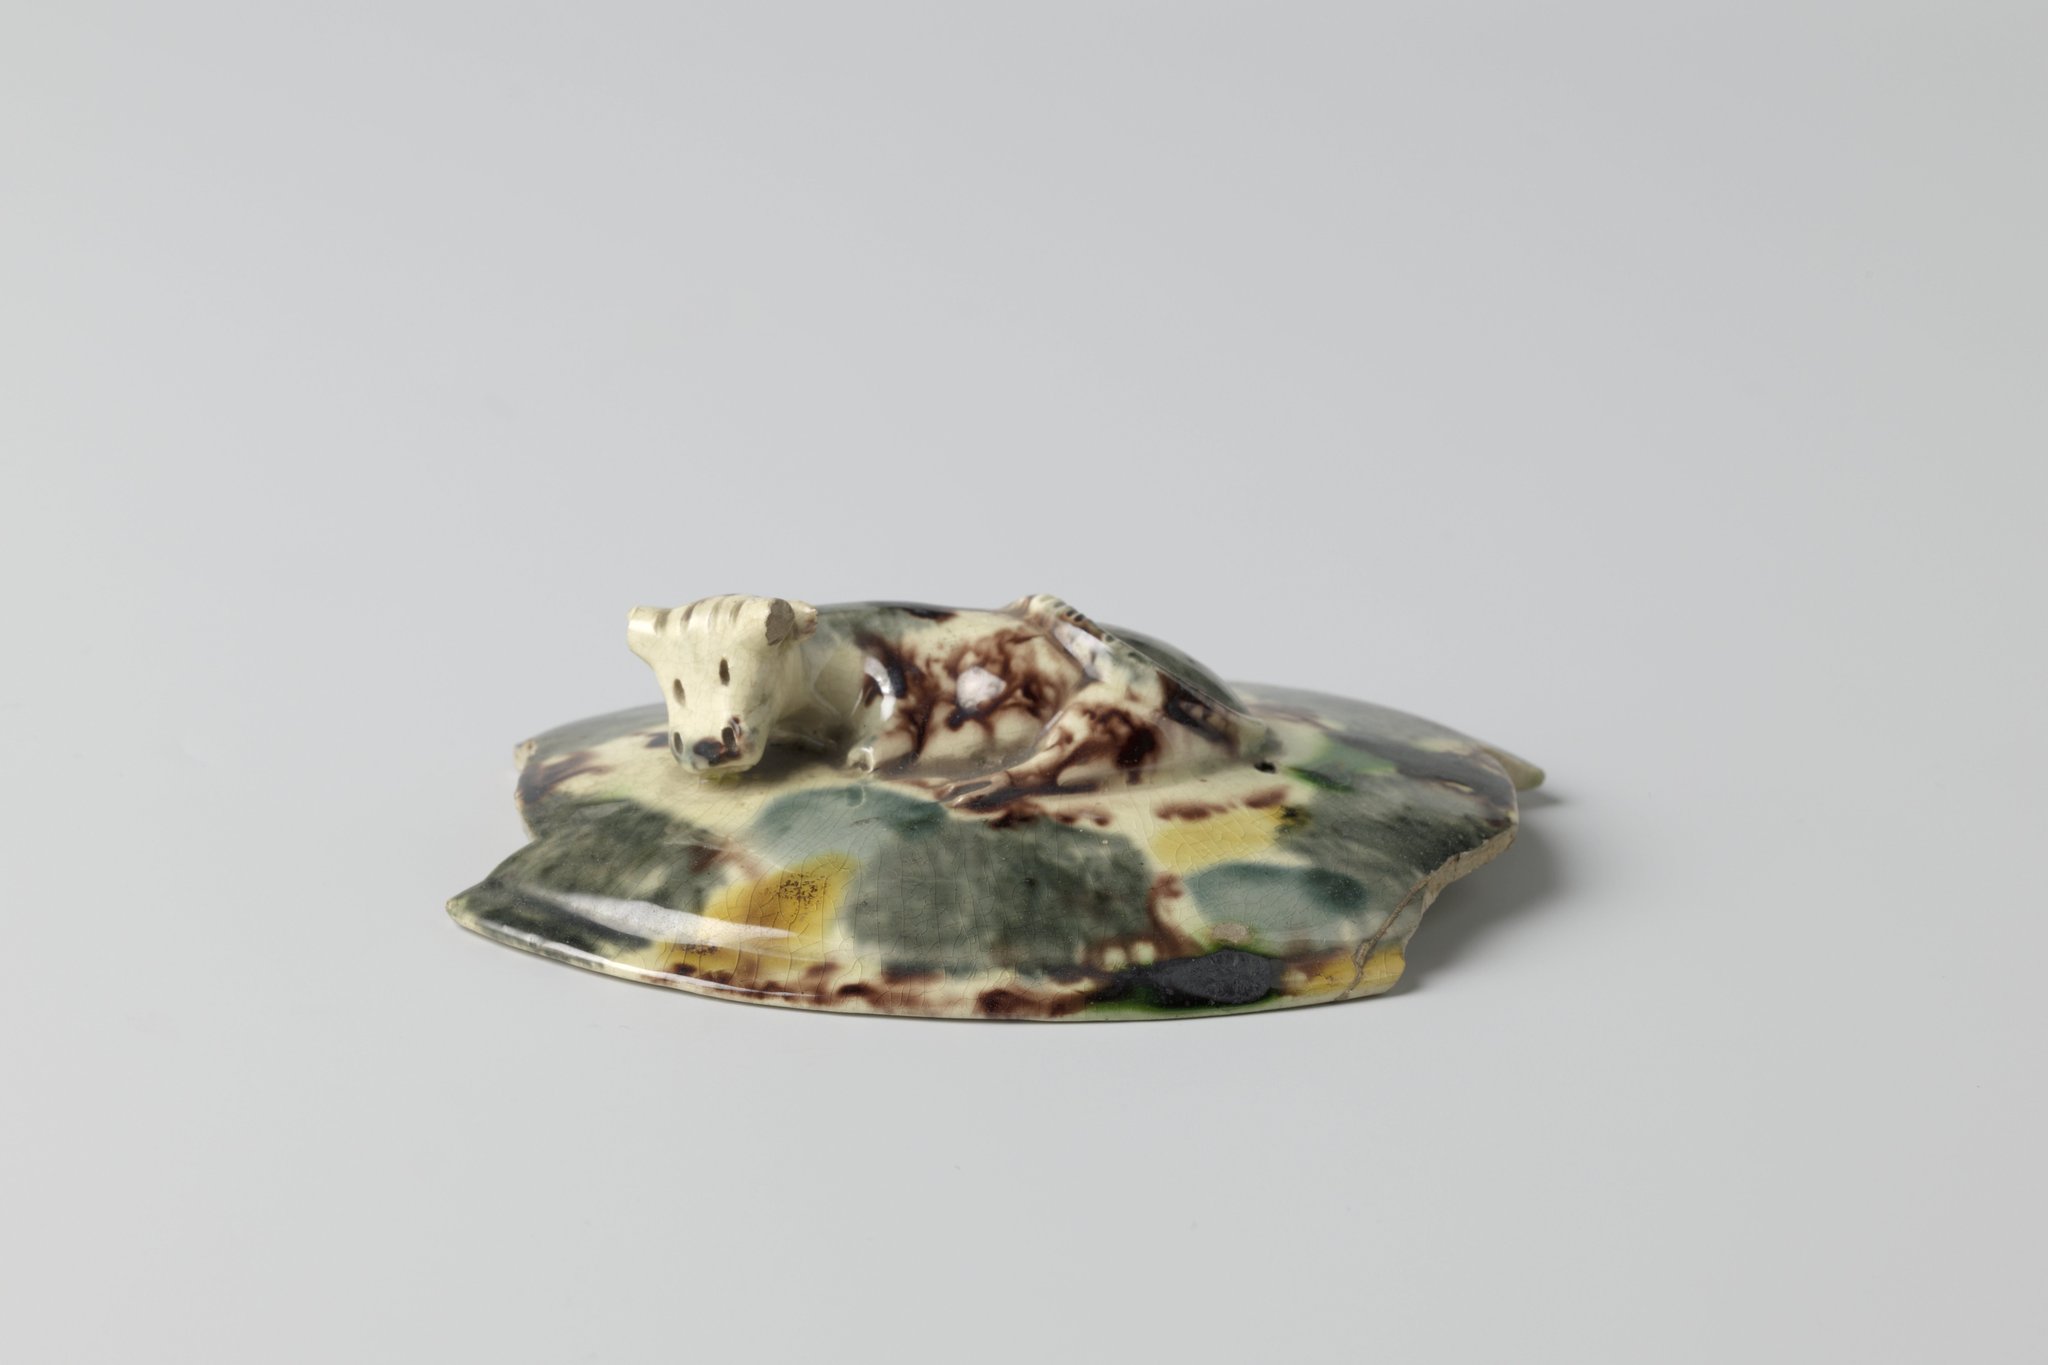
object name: lid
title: Deksel van een botervloot, van veelkleurig gebakken aardewerk; Staffordshire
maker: Anonymous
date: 1750-1770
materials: earthenware, glaze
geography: england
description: Deksel (ovaal?) van veelkleurig hardgebakken aardewerk. Het deksel heeft een knop in de vorm van een liggende koe. Het deksel hoort bij een botervloot (BK-1987-36-C) en een onderschotel (BK-1987-36-A).